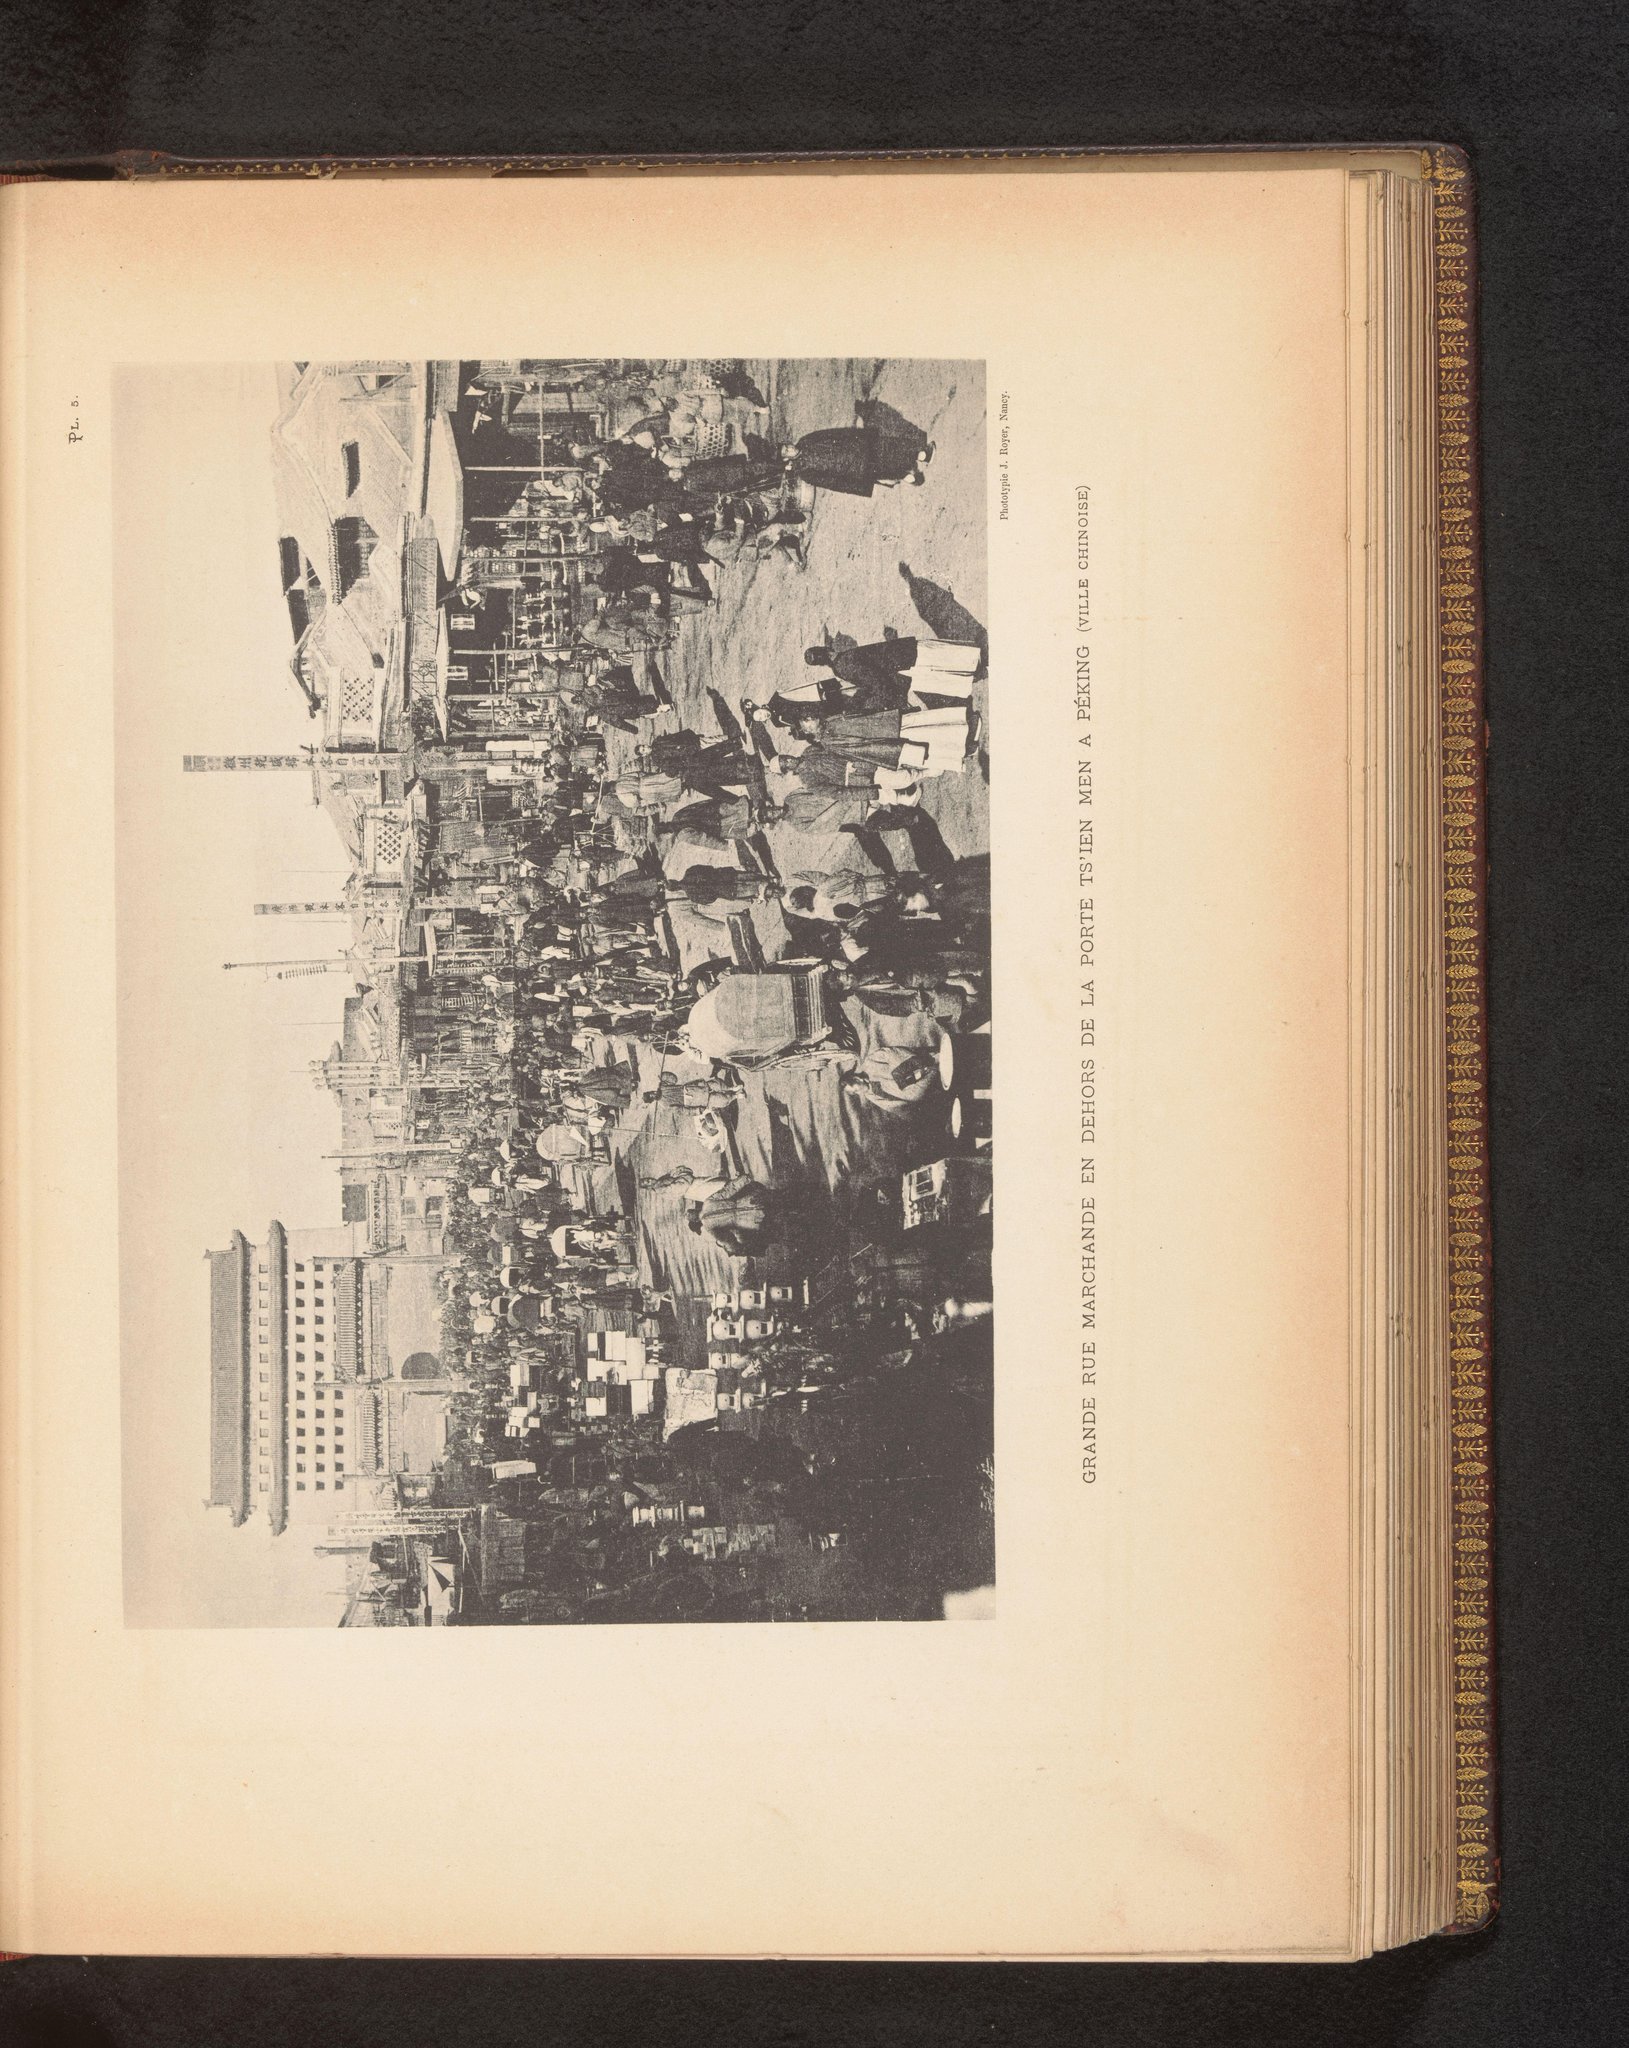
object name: photomechanical print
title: Gezicht op een drukke winkelstraat bij de Tsien-men poort te Peking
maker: jules royer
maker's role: printer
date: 1892-1897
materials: paper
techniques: photograph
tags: shop, store, gate, entrance, street